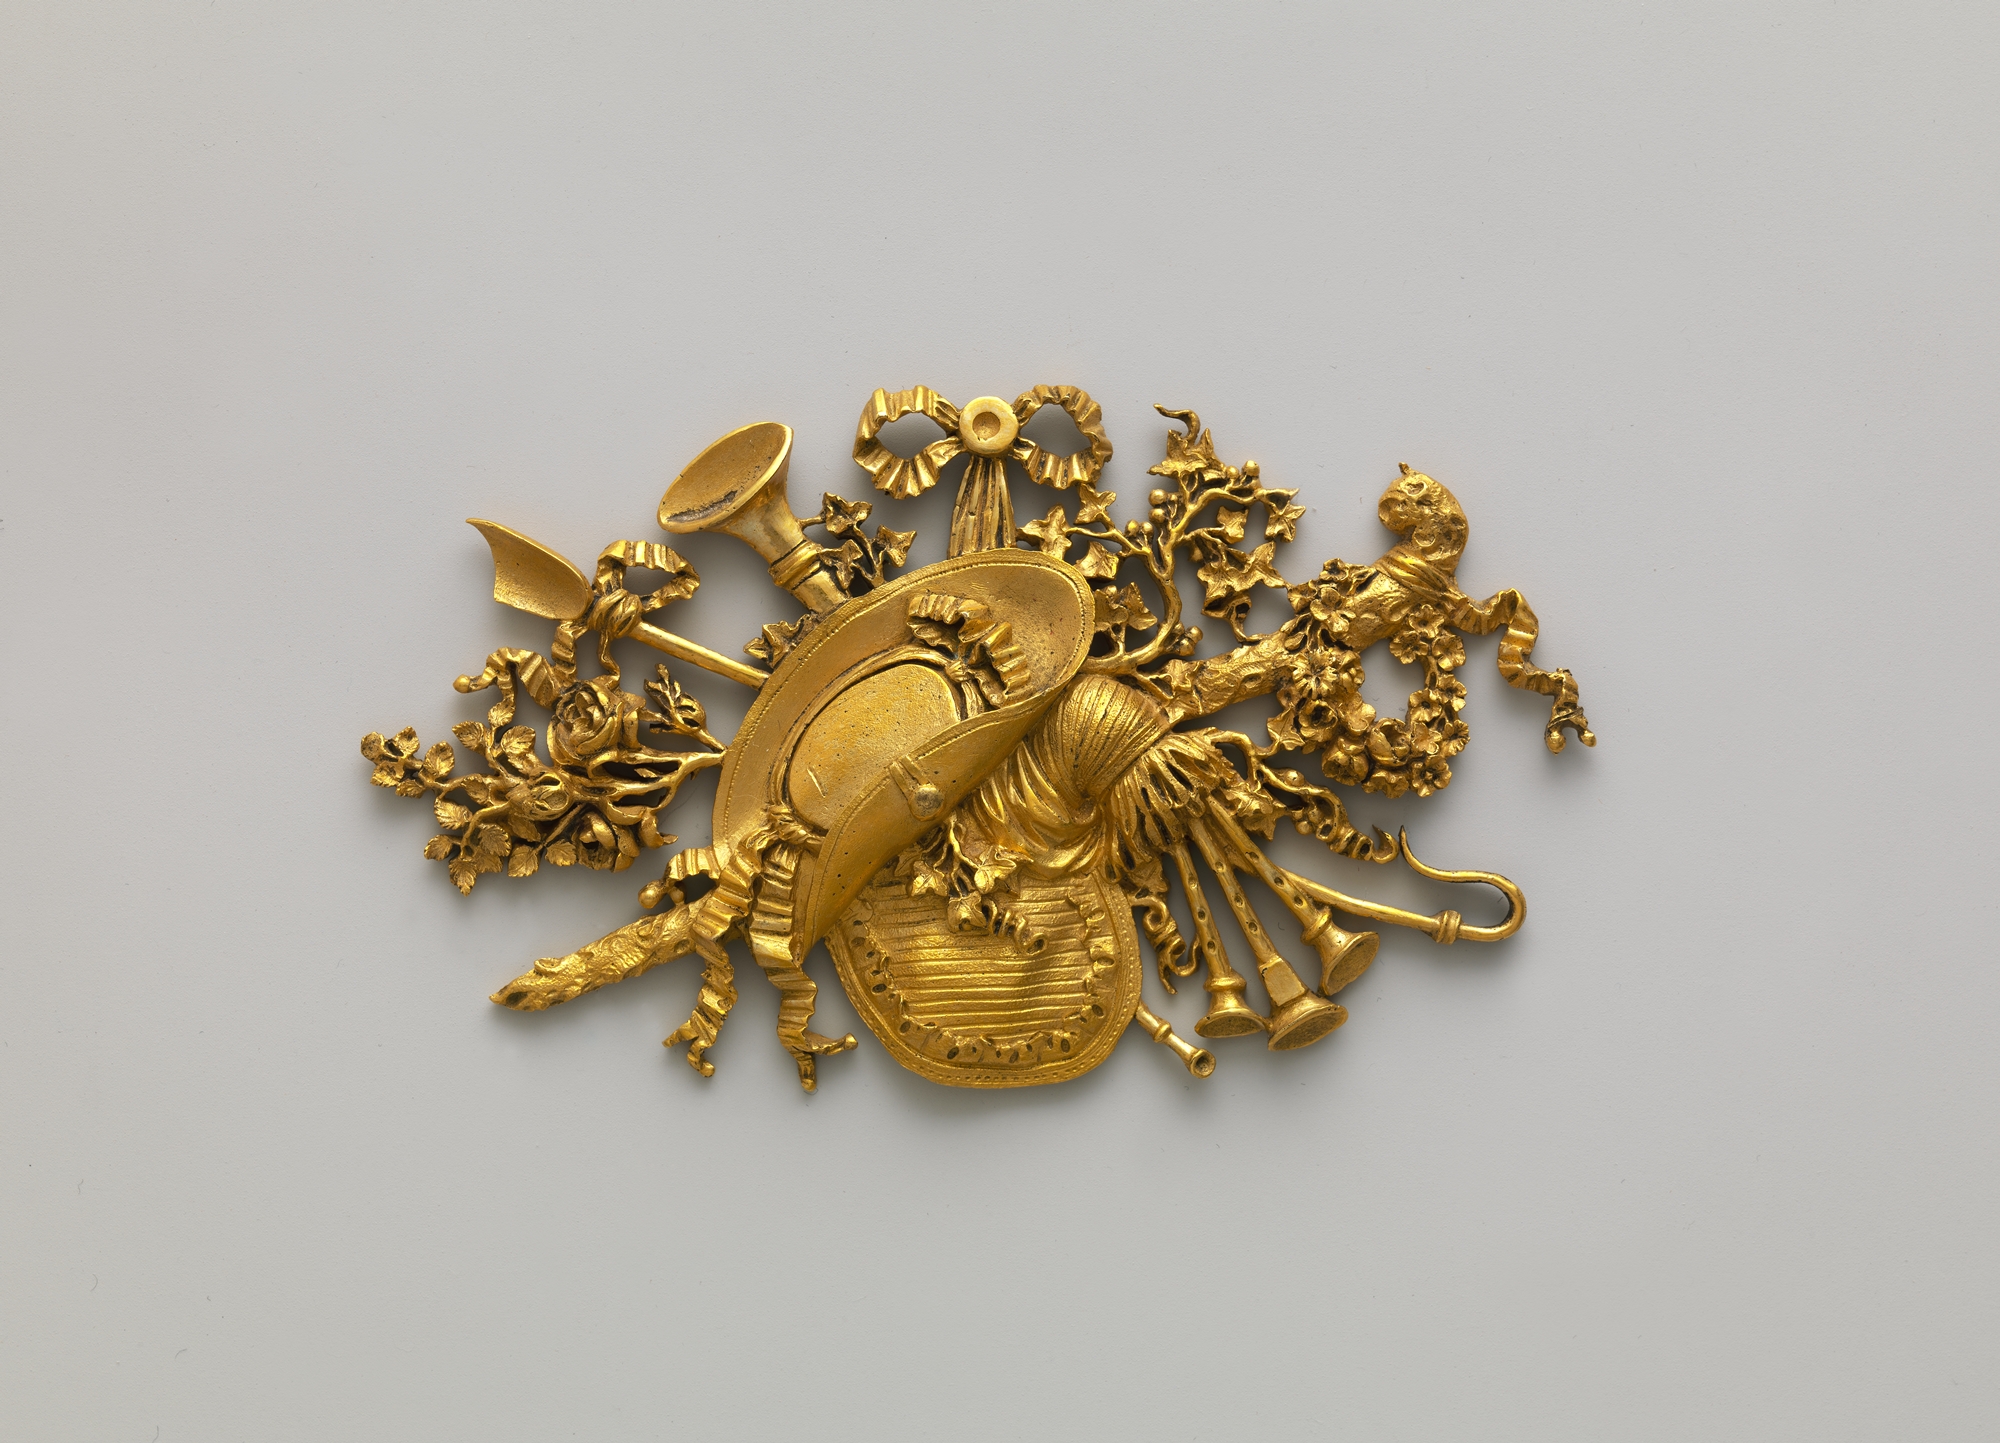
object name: panel ornament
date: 1701-1800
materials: gilt bronze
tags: musical instruments,flowers